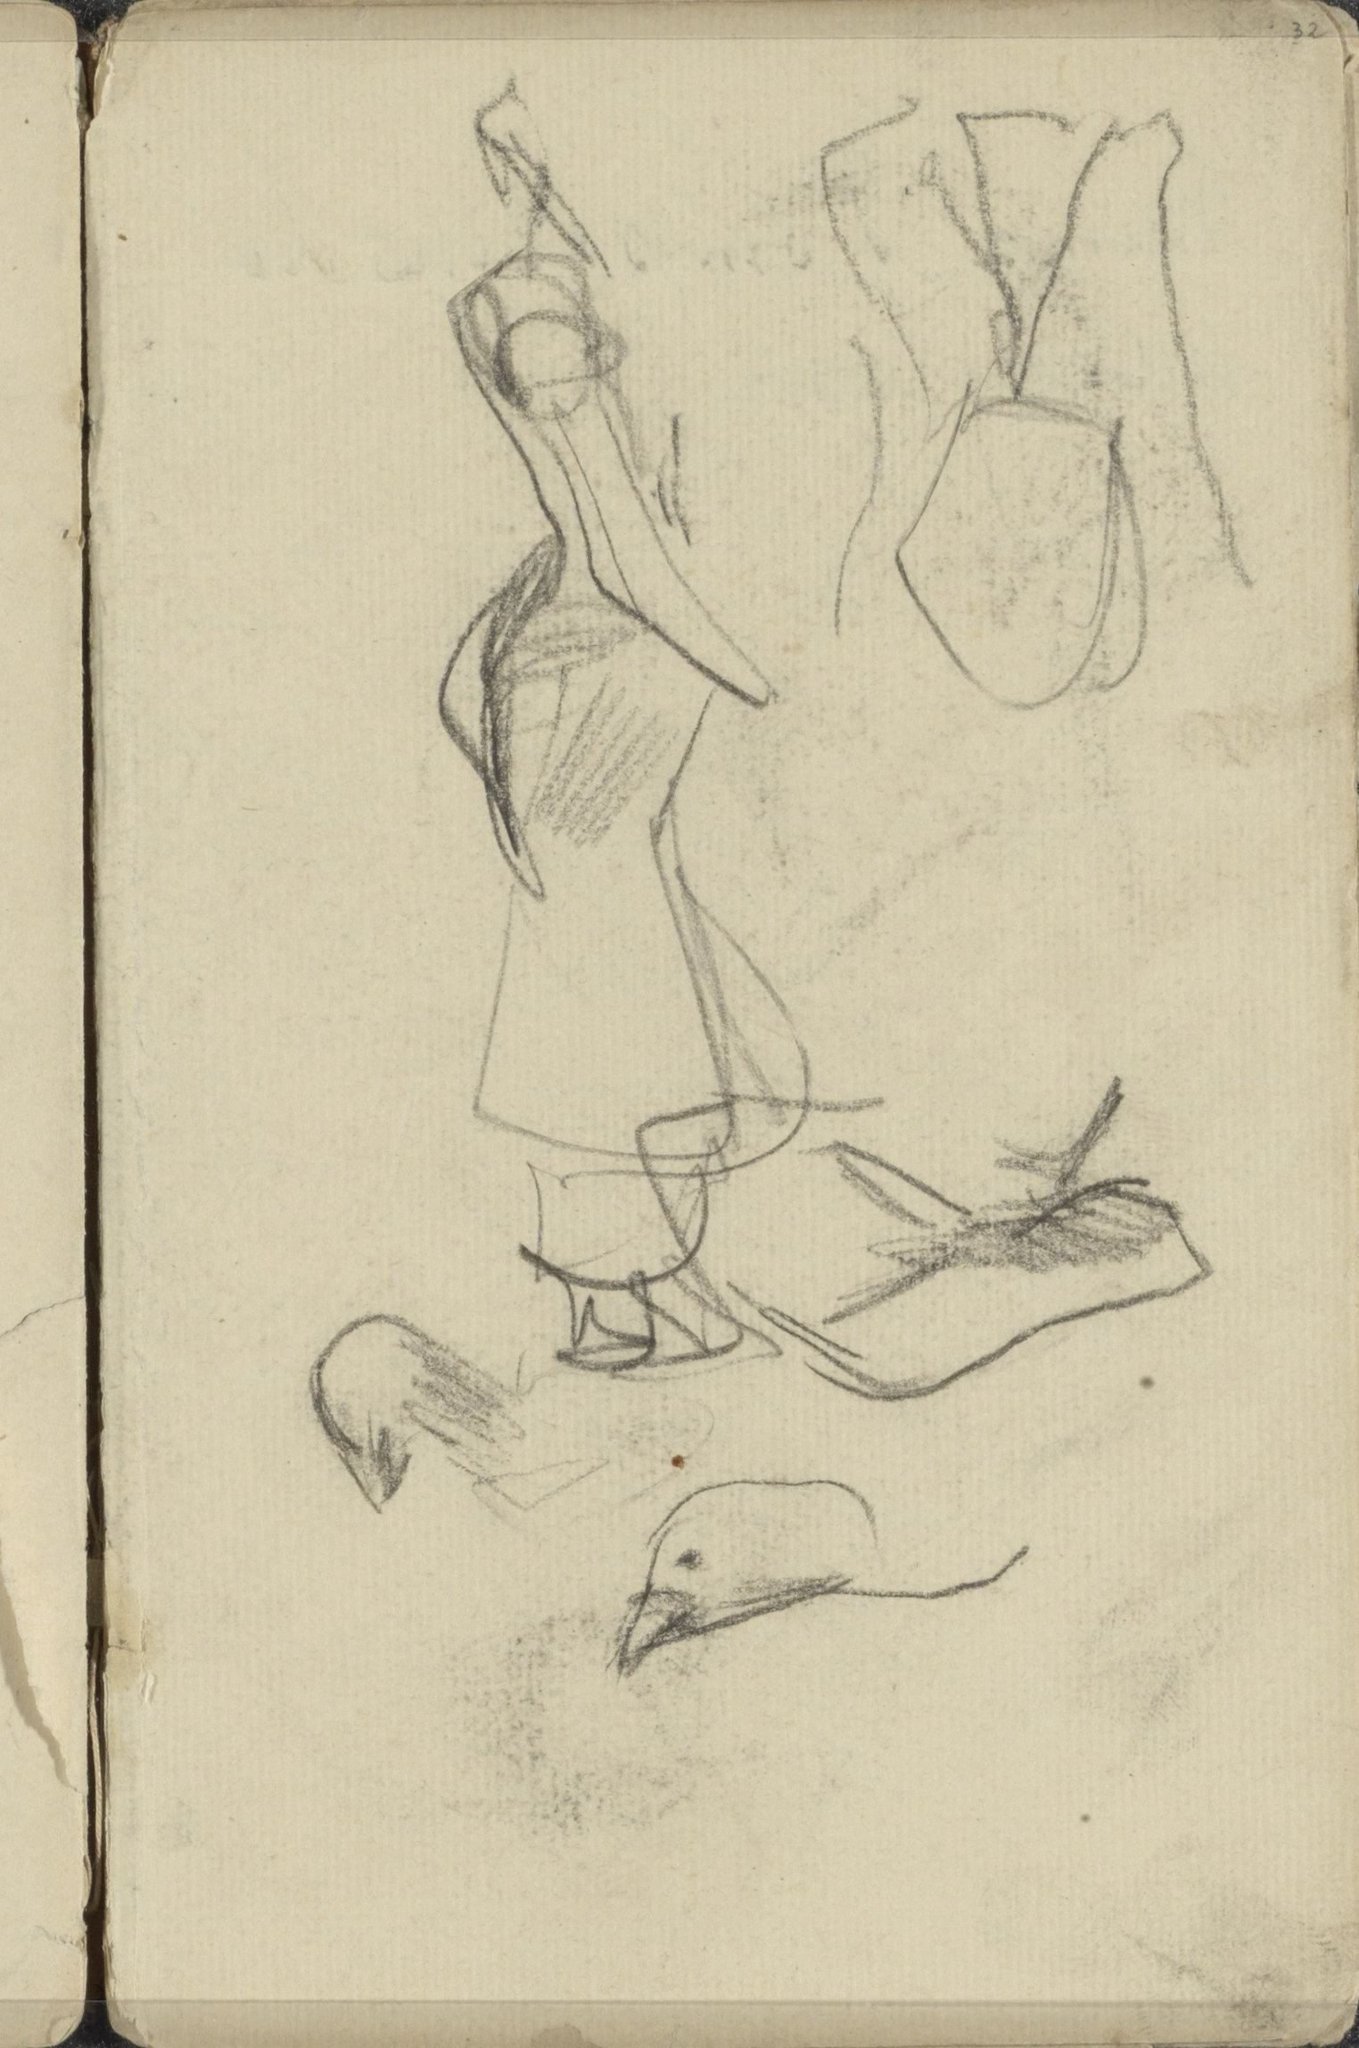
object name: sketchbook leaf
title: Studieblad met een staande vrouw en vogels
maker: george hendrik breitner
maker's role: draughtsman, painter, print maker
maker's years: 1857-1923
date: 1880-1882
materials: chalk, paper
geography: the hague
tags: water-birds: goose, standing figure - aa - female human figure (+ sideview, profile)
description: Mogelijk ganzen. Pagina 32 uit een schetsboek met 19 bladen.